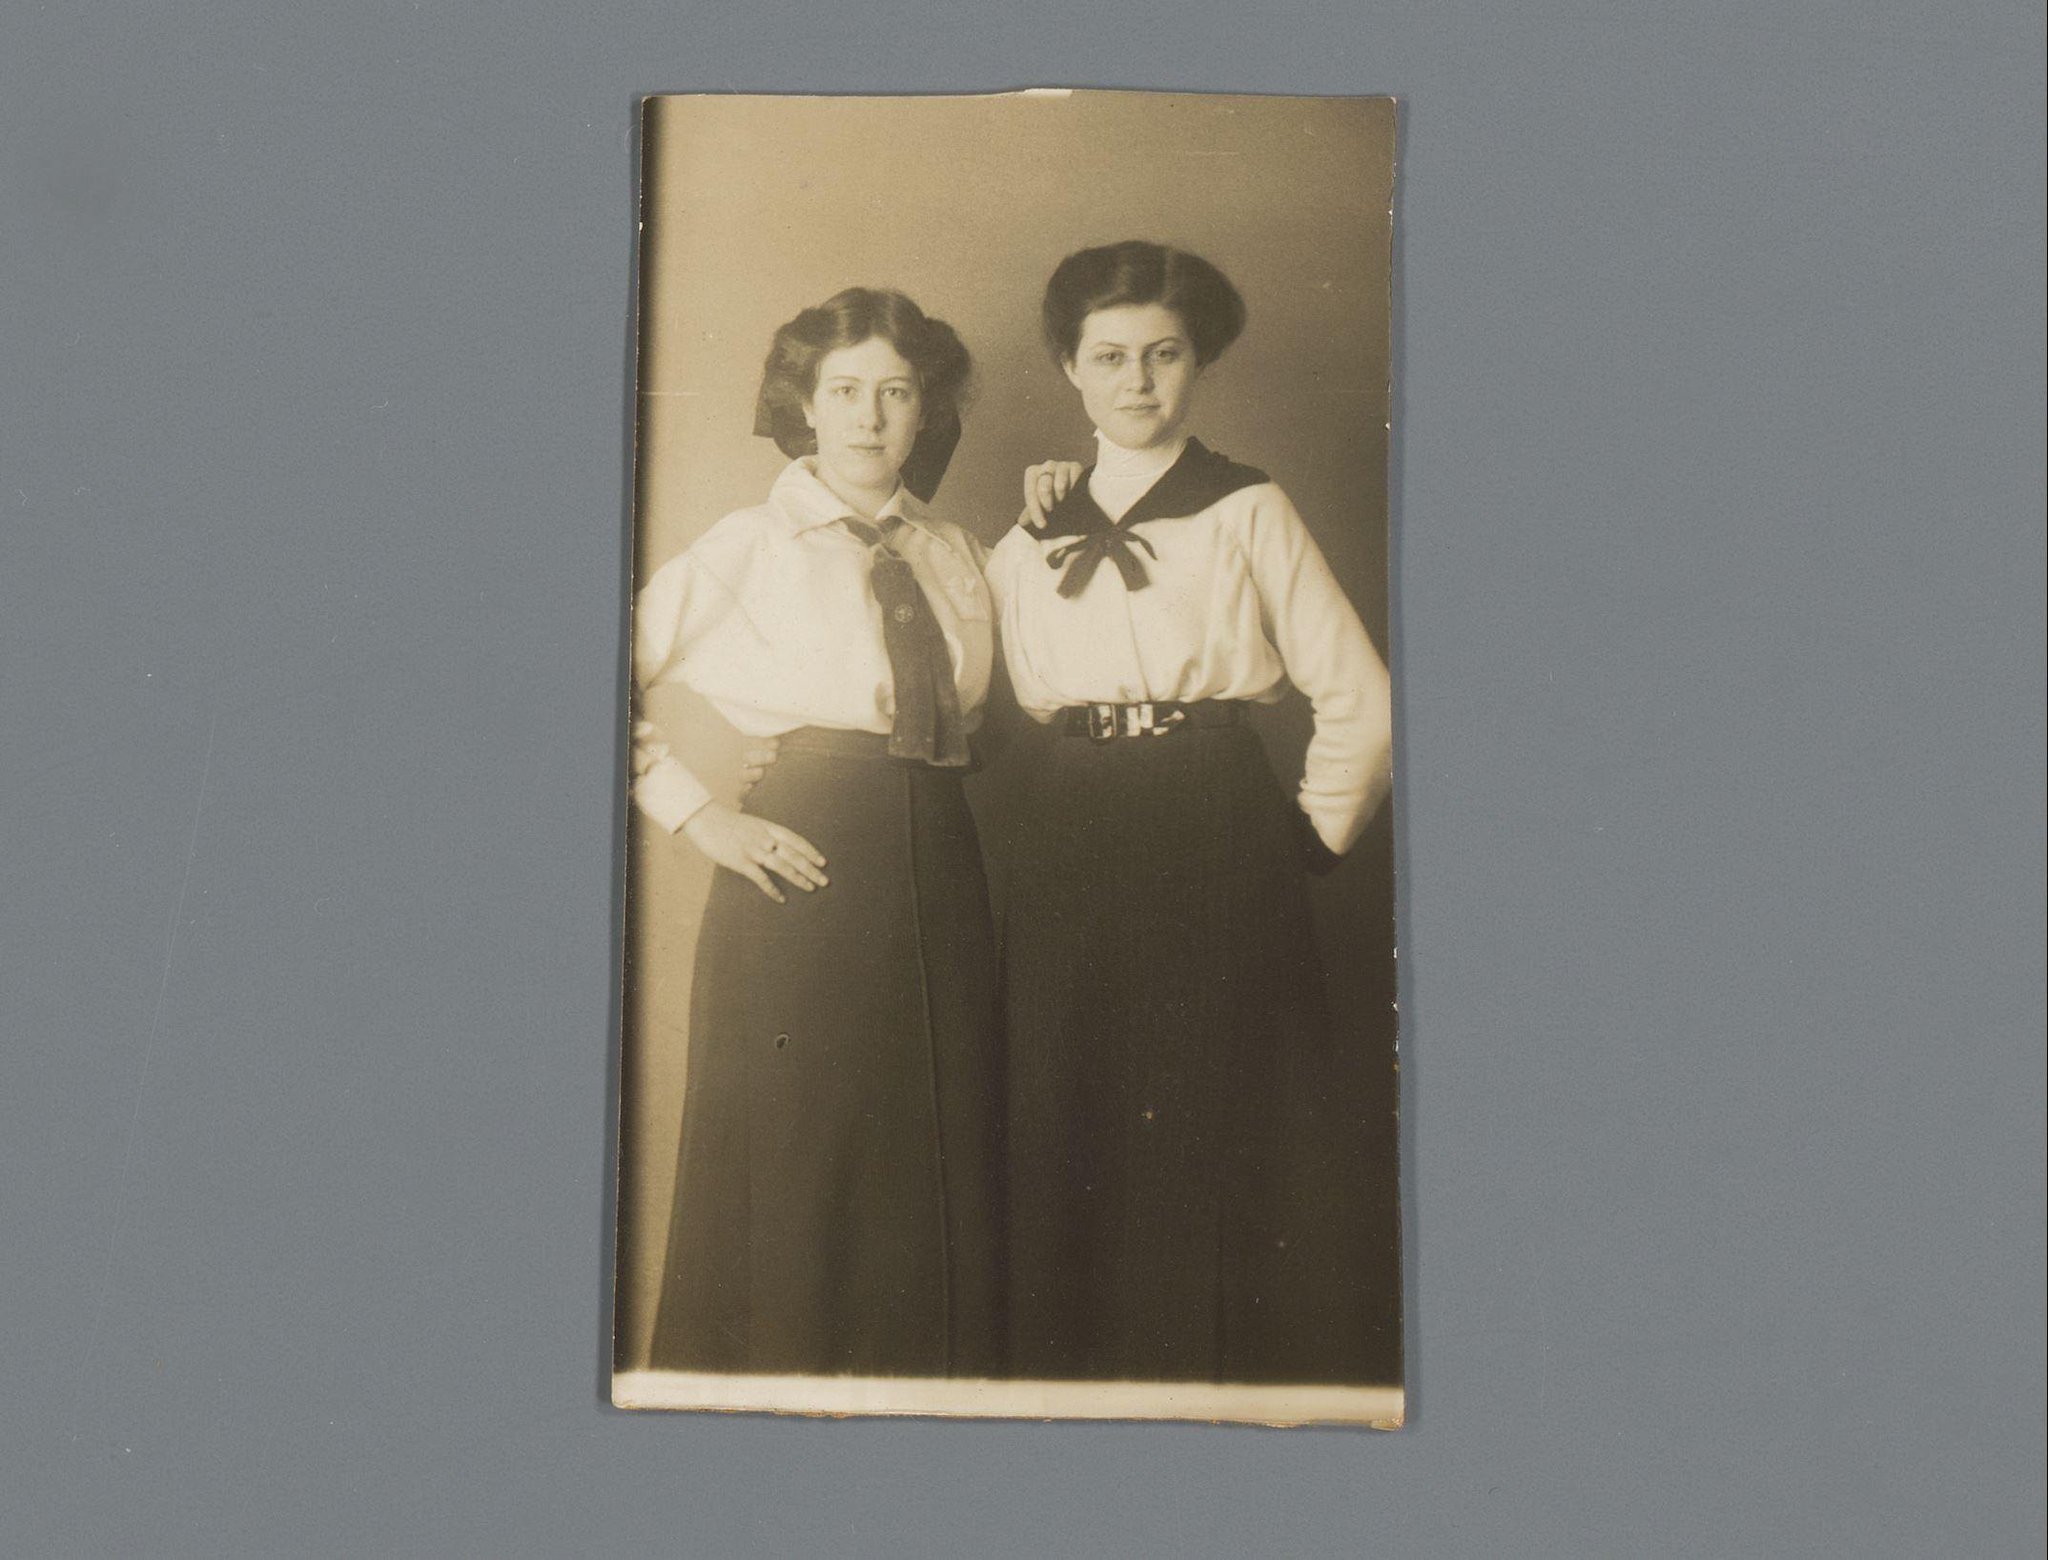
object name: snapshot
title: Dubbelportret van twee onbekende jonge vrouwen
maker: Anonymous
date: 1912-1918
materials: paper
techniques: gelatin silver print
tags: adolescent, young woman, maiden